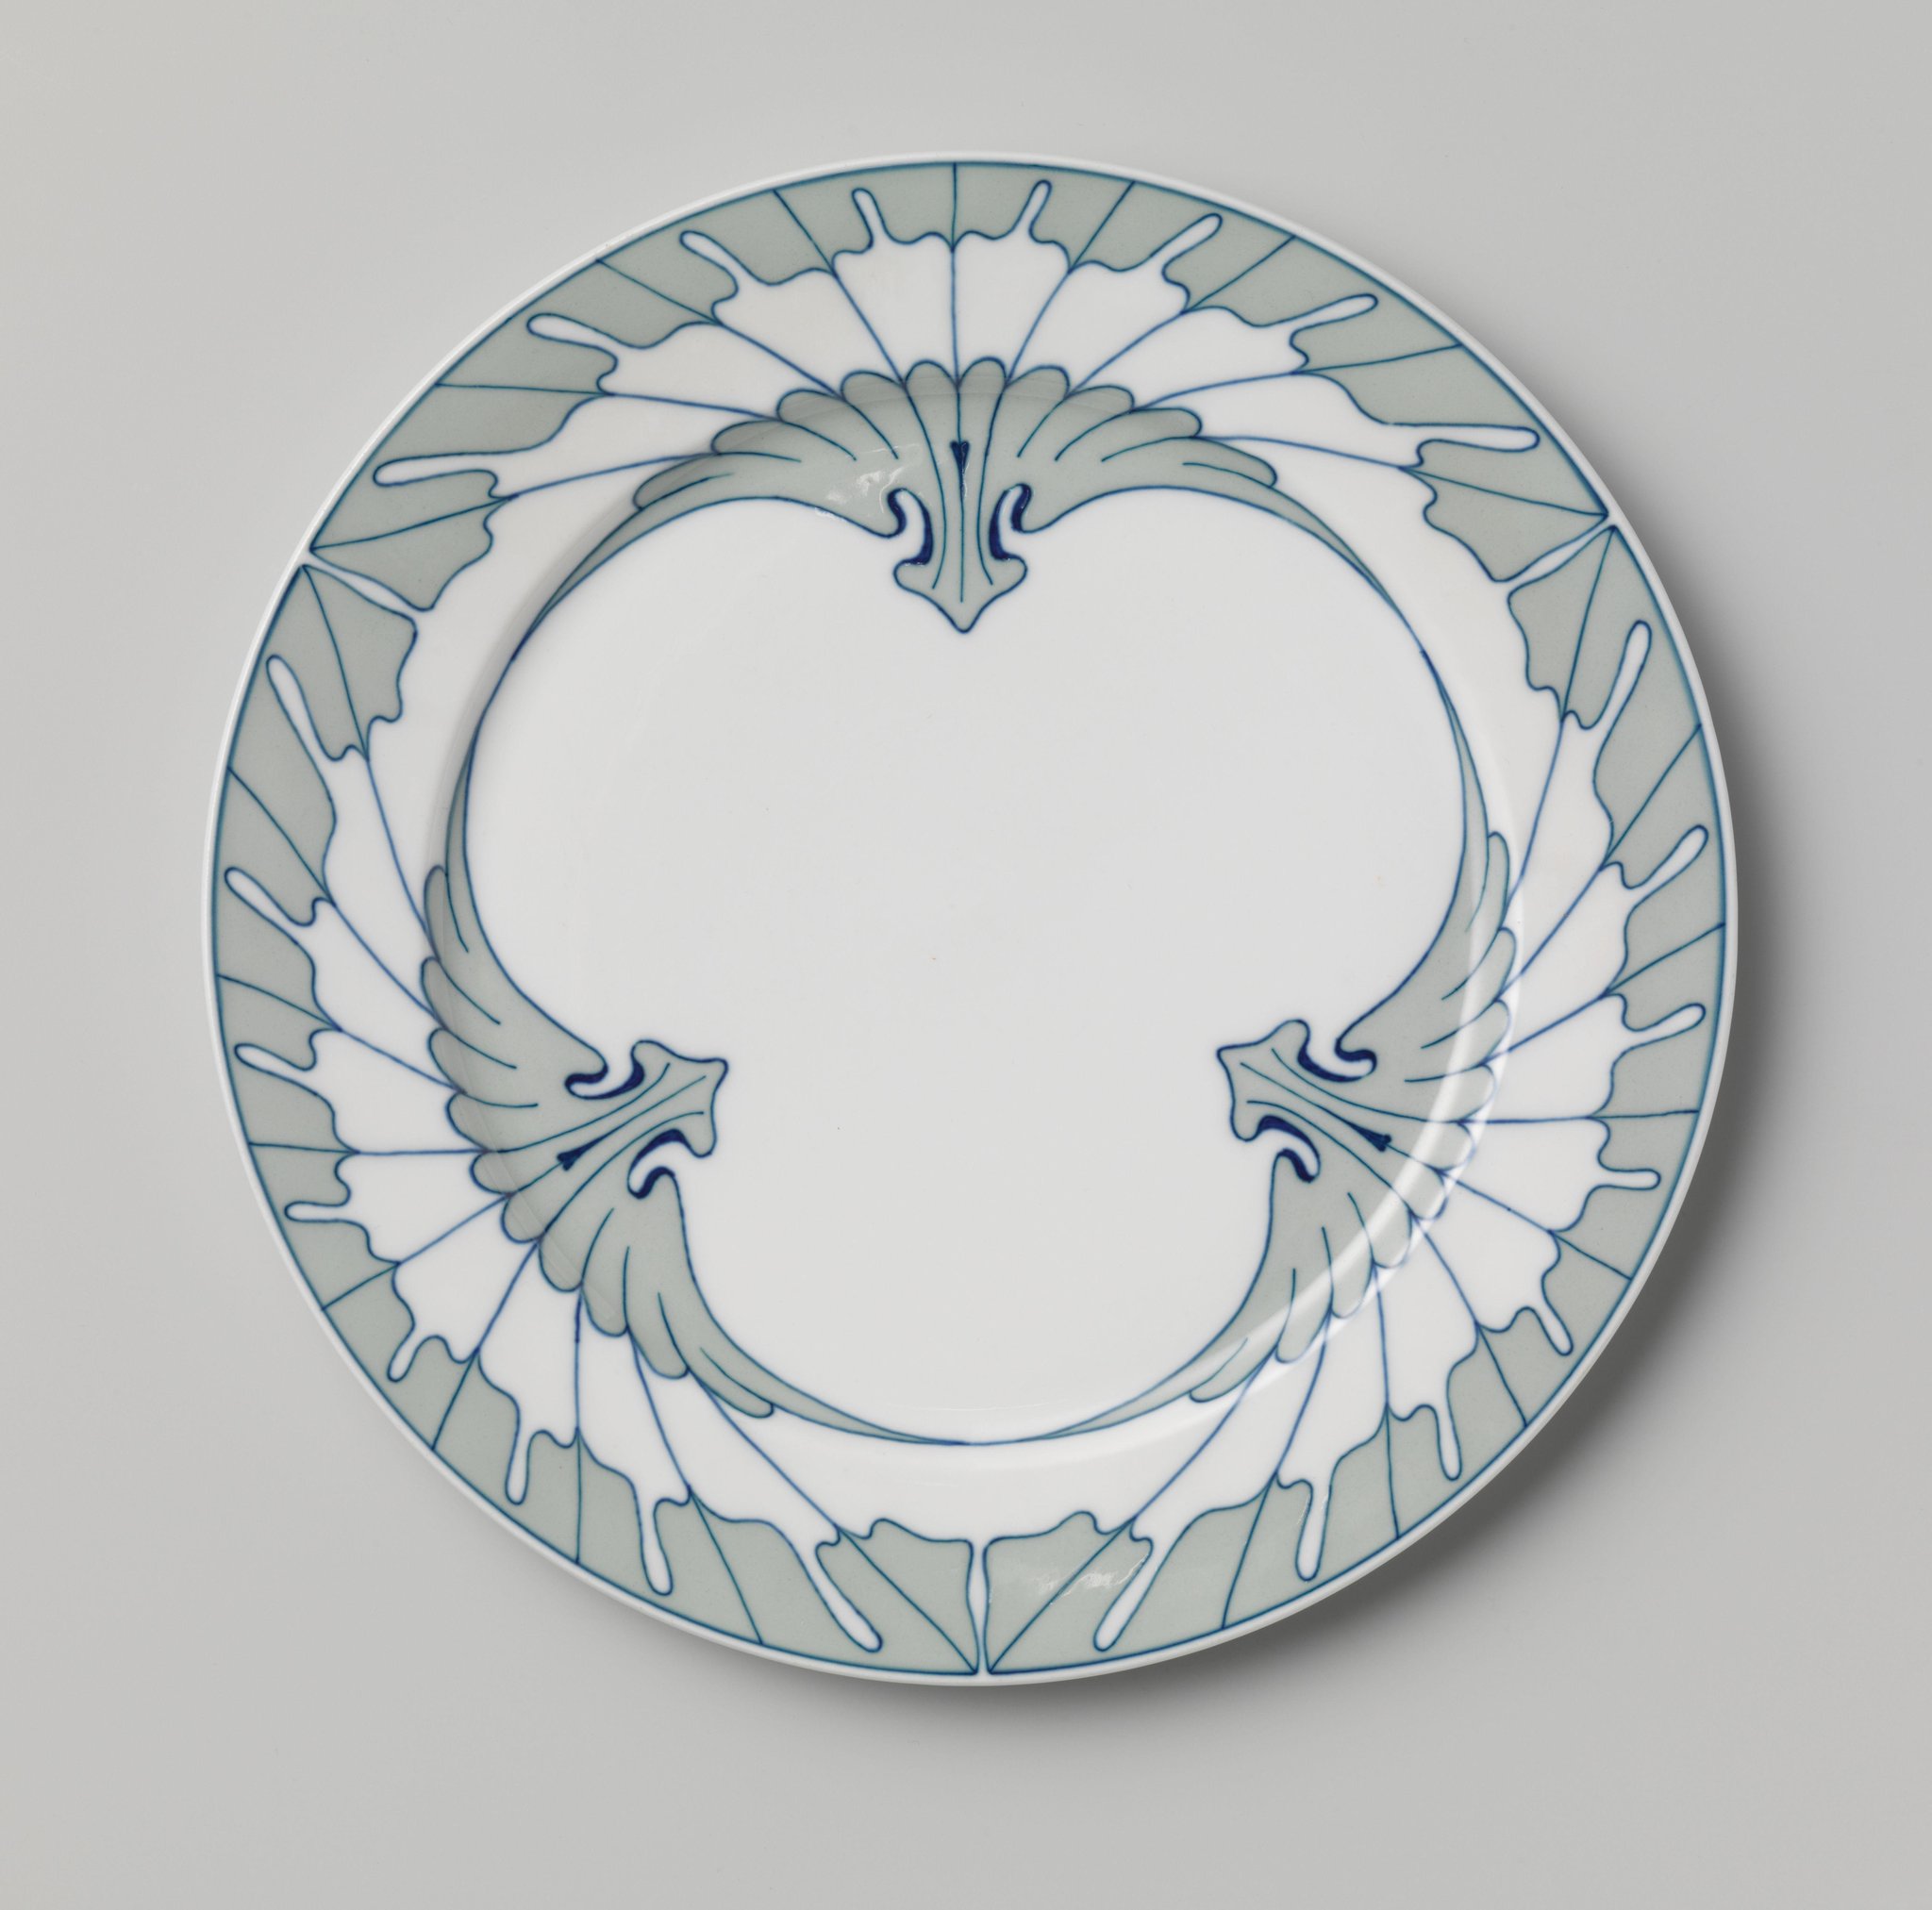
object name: eating drinking utensil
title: Bord, beschilderd met het Flügelmuster-decor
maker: konrad hentschel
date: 1901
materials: porcelain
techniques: painted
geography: meissen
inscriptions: factory mark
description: Bord van beschilderd porselein. Het bord is beschilderd in groen en blauw met het Flügelmuster. Het bord hoort bij een servies (BK-1976-65-1 t/m BK-1976-65-34) en is gemerkt.